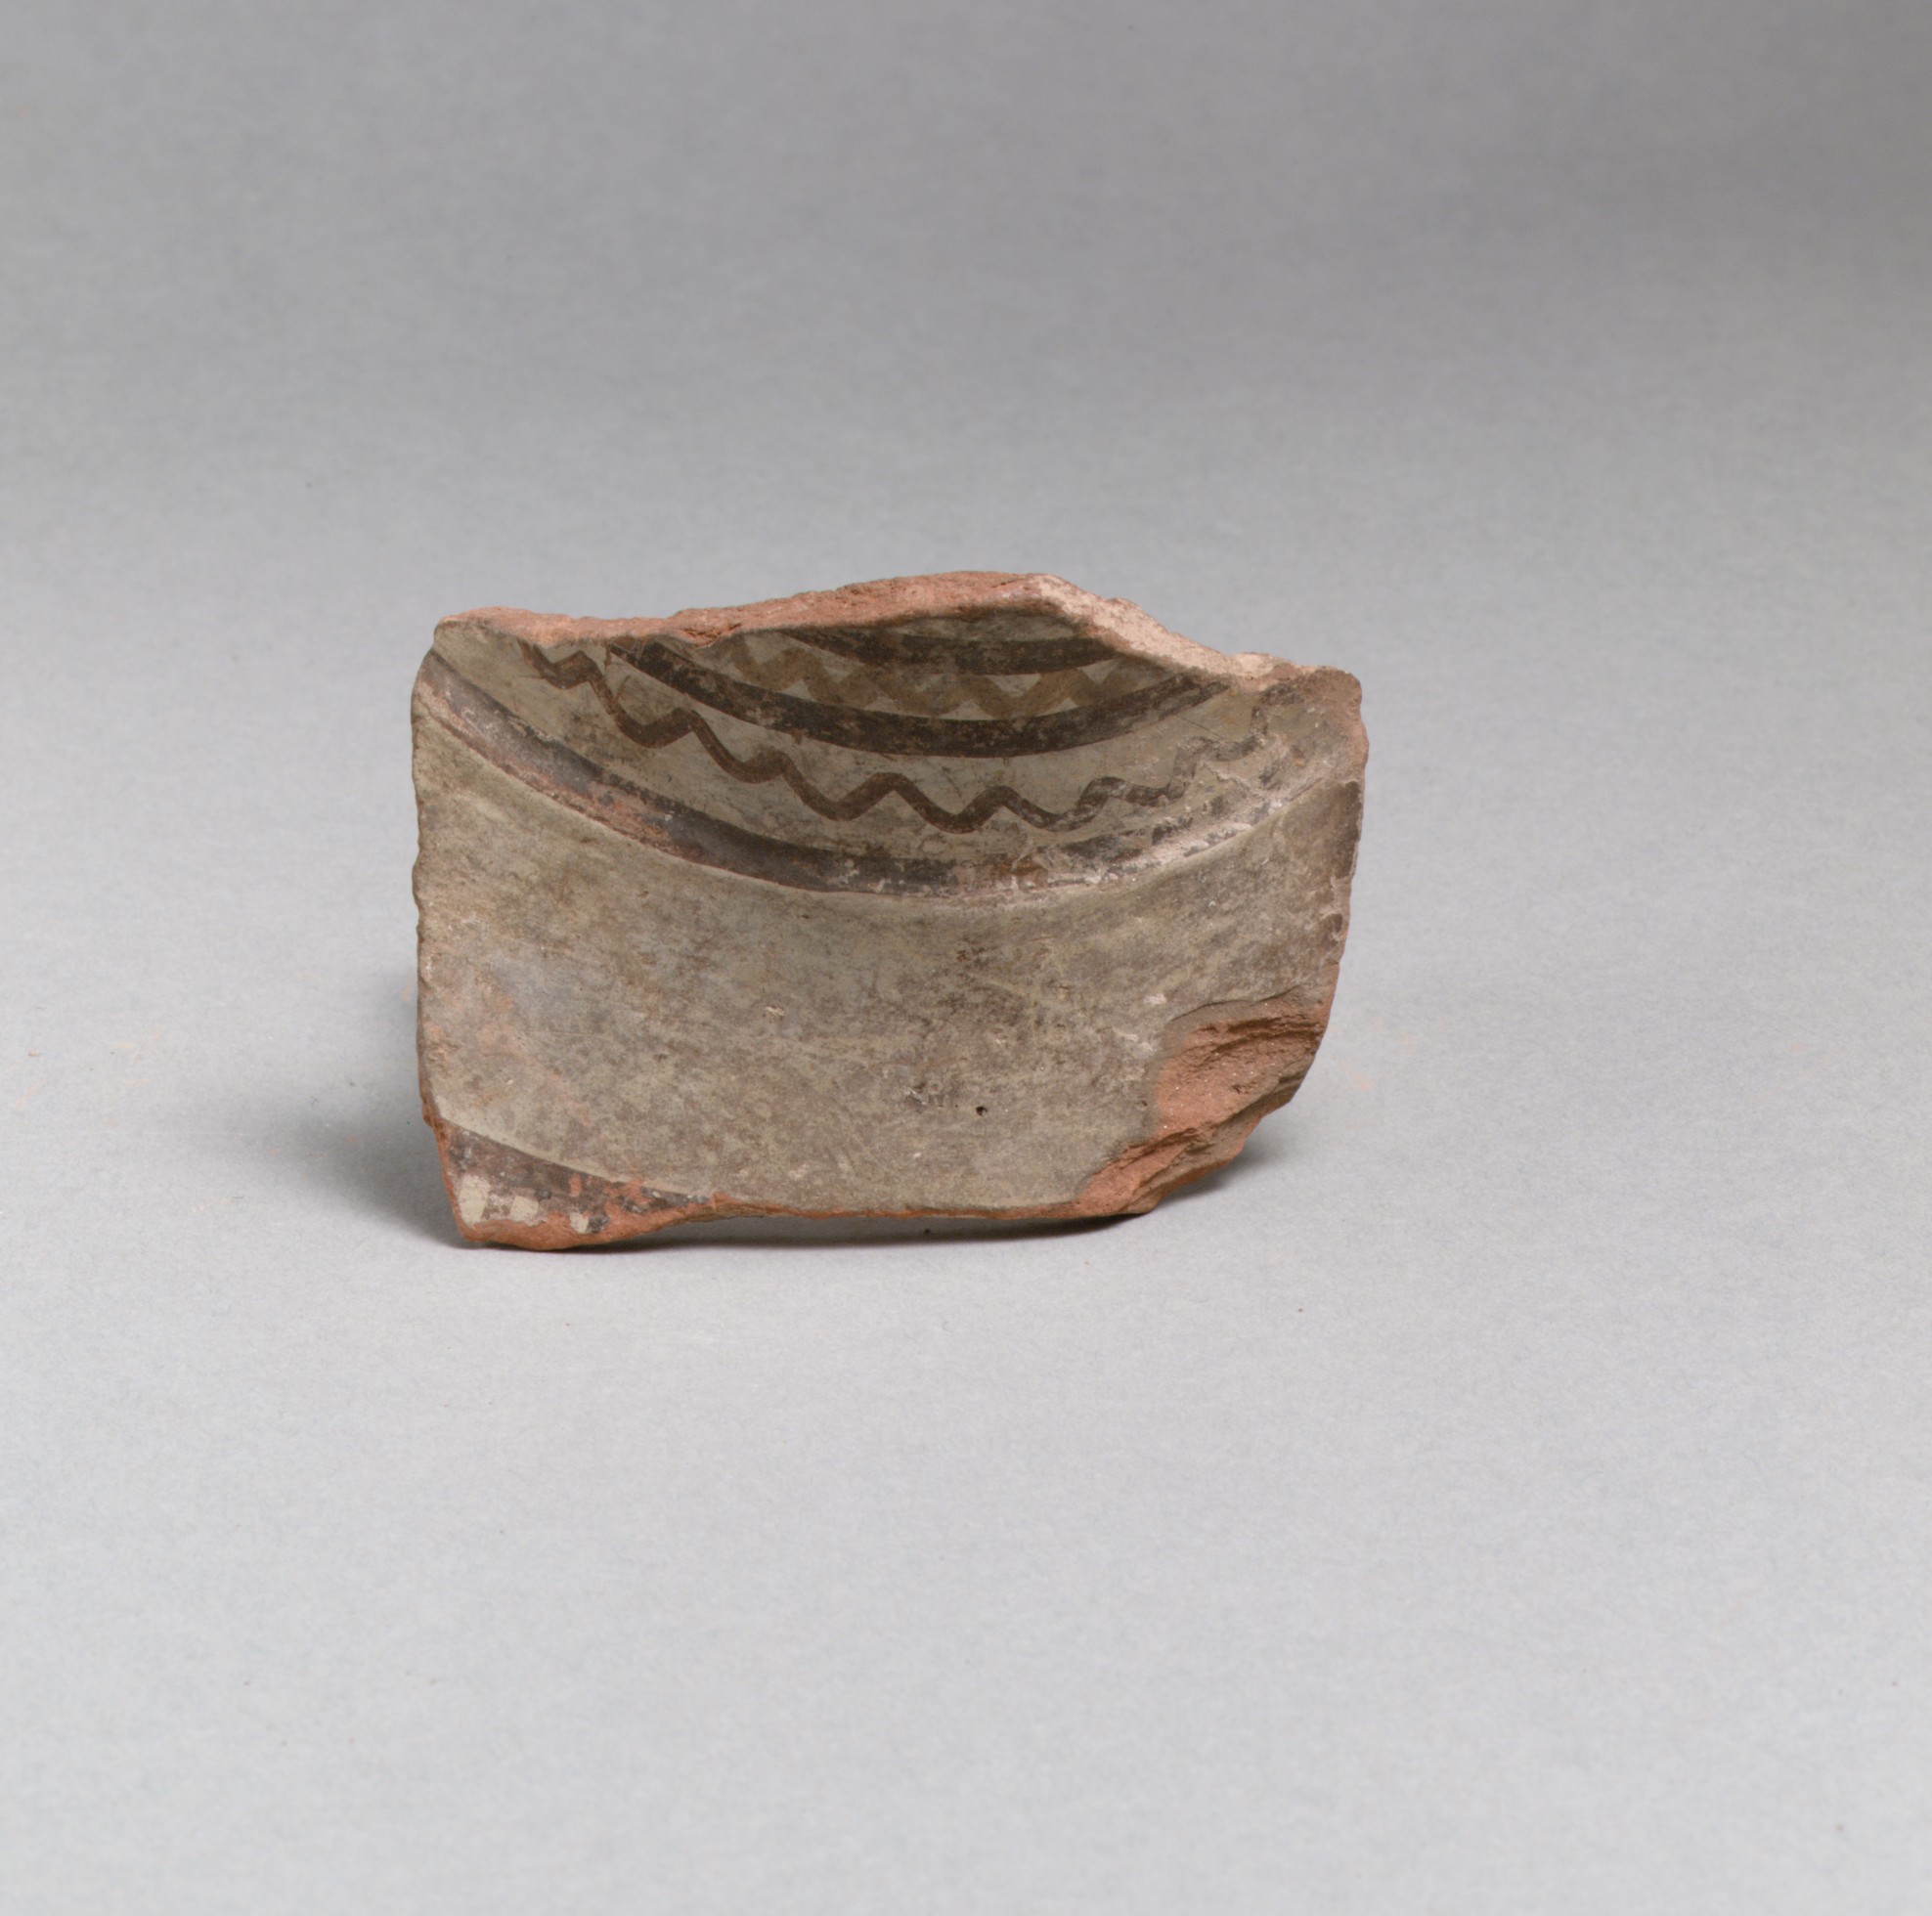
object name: vase fragment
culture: greek or lydian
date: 1050-700 BCE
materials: terracotta